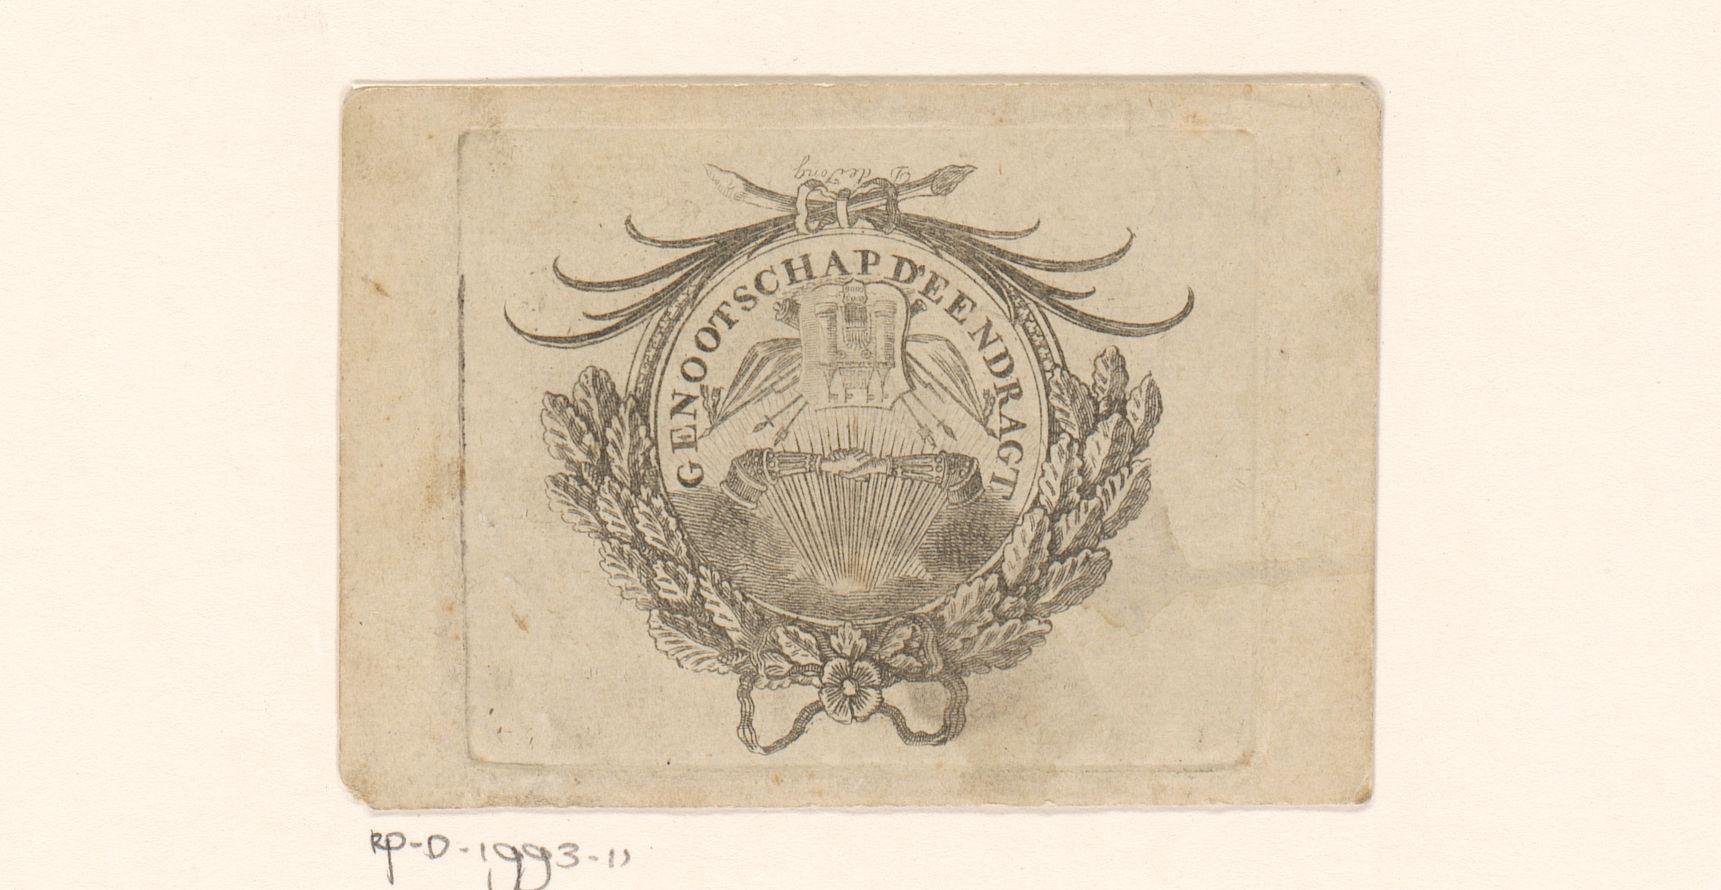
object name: membership certificate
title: Lidmaatschapsbewijs van Genootschap d'Eendragt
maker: l. de jong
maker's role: print maker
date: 1787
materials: paper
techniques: engraving, etching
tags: coat of arms (as symbol of the state, etc.), shaking hands, 'dextrarum junctio'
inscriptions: collector's mark: Lugt 2228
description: Op de voorzijde een rond vignet met handen boven een stadswapen met daarachter banieren en in het halfrond 'Genootschap d'Eendragt'. Op de achterzijde de lidmaatschapstekst: 'Gorinchem 1787. Mejuffrouw J.M. Hoogvliet lid honorair. Mr. C. Boonzajer, secretaris'.